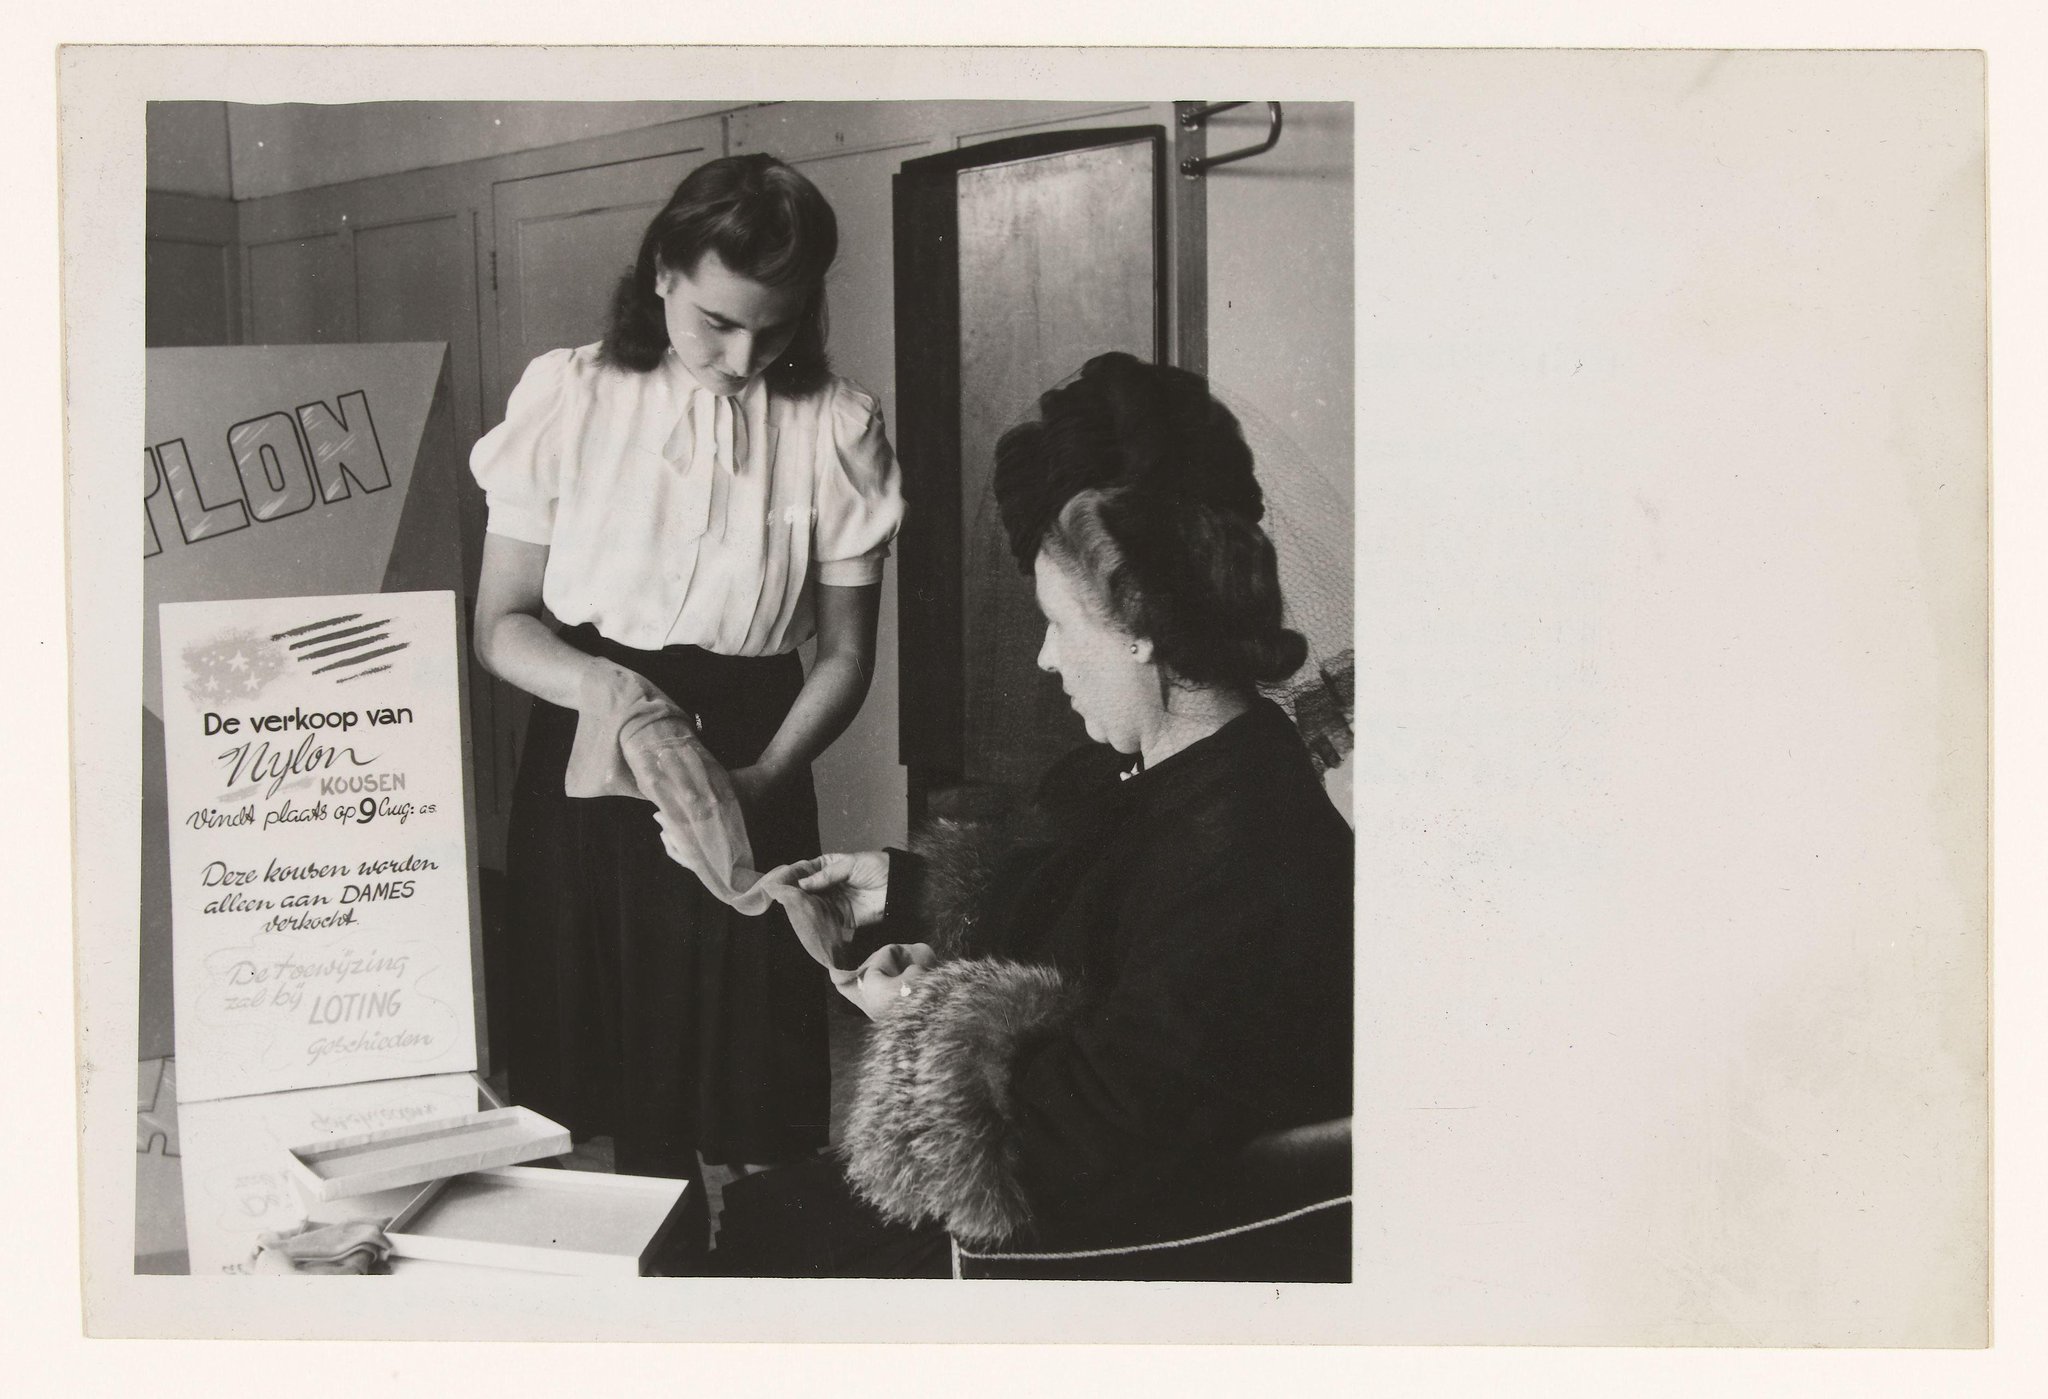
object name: documentary photograph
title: De kousenloterij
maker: theo van haren noman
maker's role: cineast, fotograaf, regisseur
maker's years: 1917-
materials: photographic support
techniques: photography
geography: amsterdam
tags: amsterdam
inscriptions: number: ‘18825’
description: In een winkel bekijken twee dames nylonkousen met het oog op de komende verkoop van deze fel begeerde kledingstukken middels een loterij. Links op de foto staat een bord met de volgende tekst: 'De verkoop van Nylon kousen vindt plaats op 9 augustus aanstaande. Deze kousen worden alleen aan dames verkocht. De toewijzing zal bij loting geschieden.'